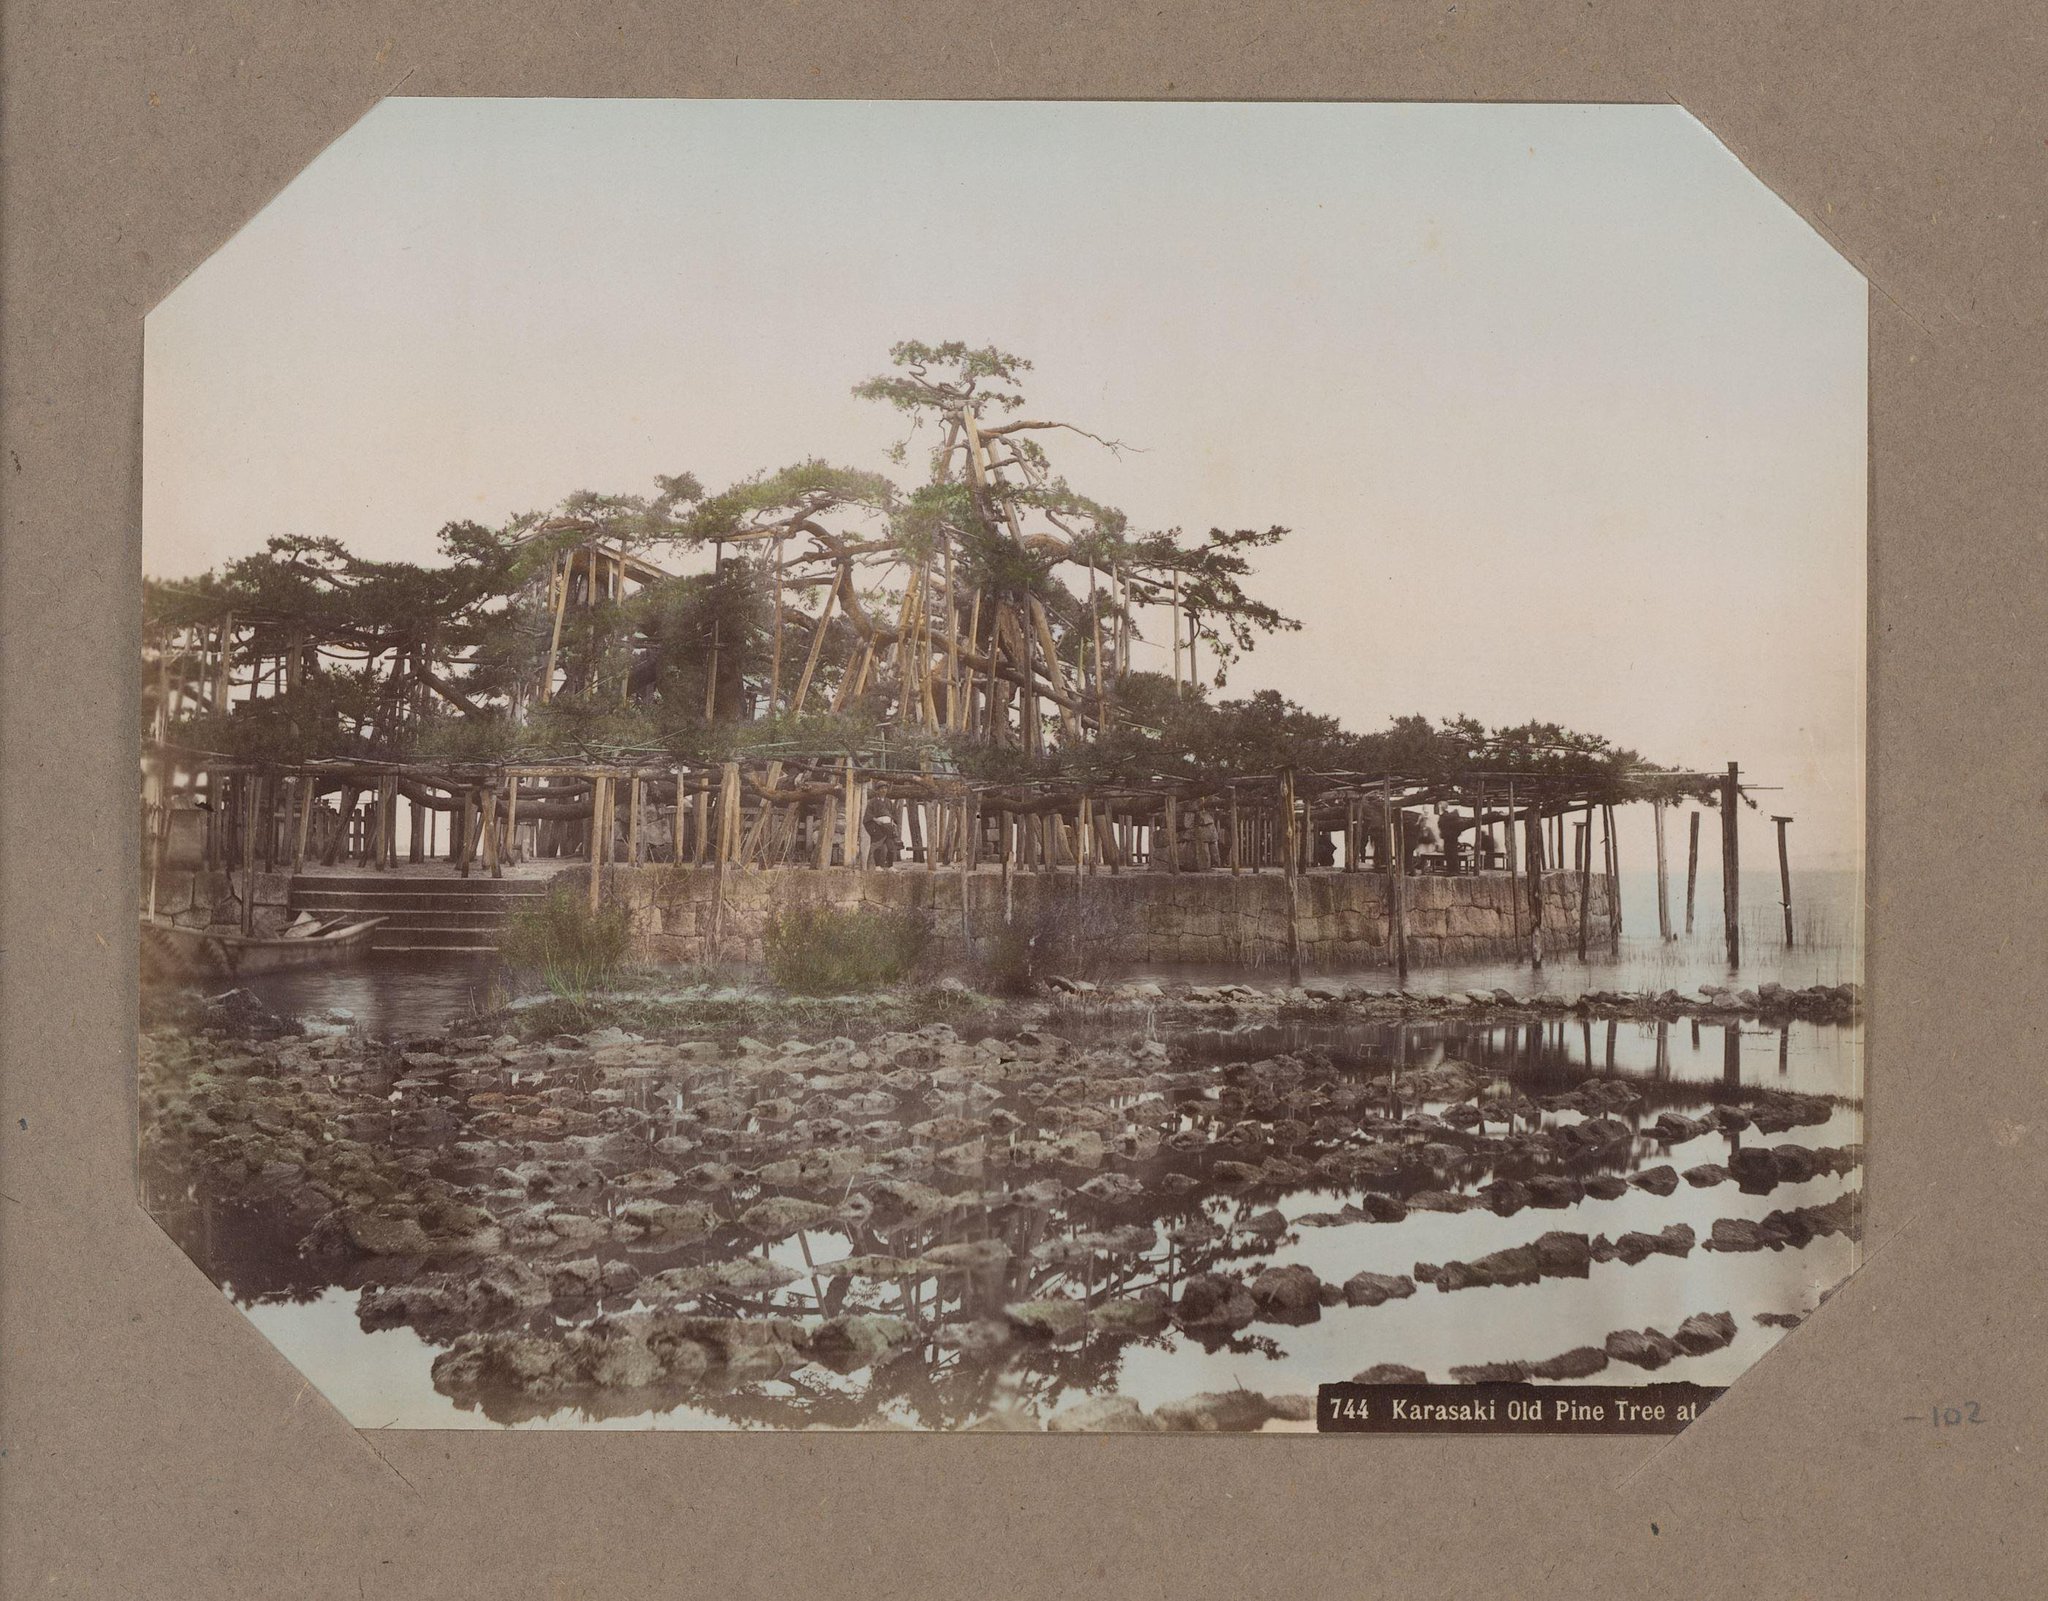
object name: album leaf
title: Oude Karasaki pijnboom aan het Biwameer, Japan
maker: Anonymous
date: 1890-1903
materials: paper, photographic support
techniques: albumen print, hand coloring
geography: biwameer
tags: lake, trees: pine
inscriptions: inscription: ‘744 Karasaki Old Pine Tree at Biwa Lake’